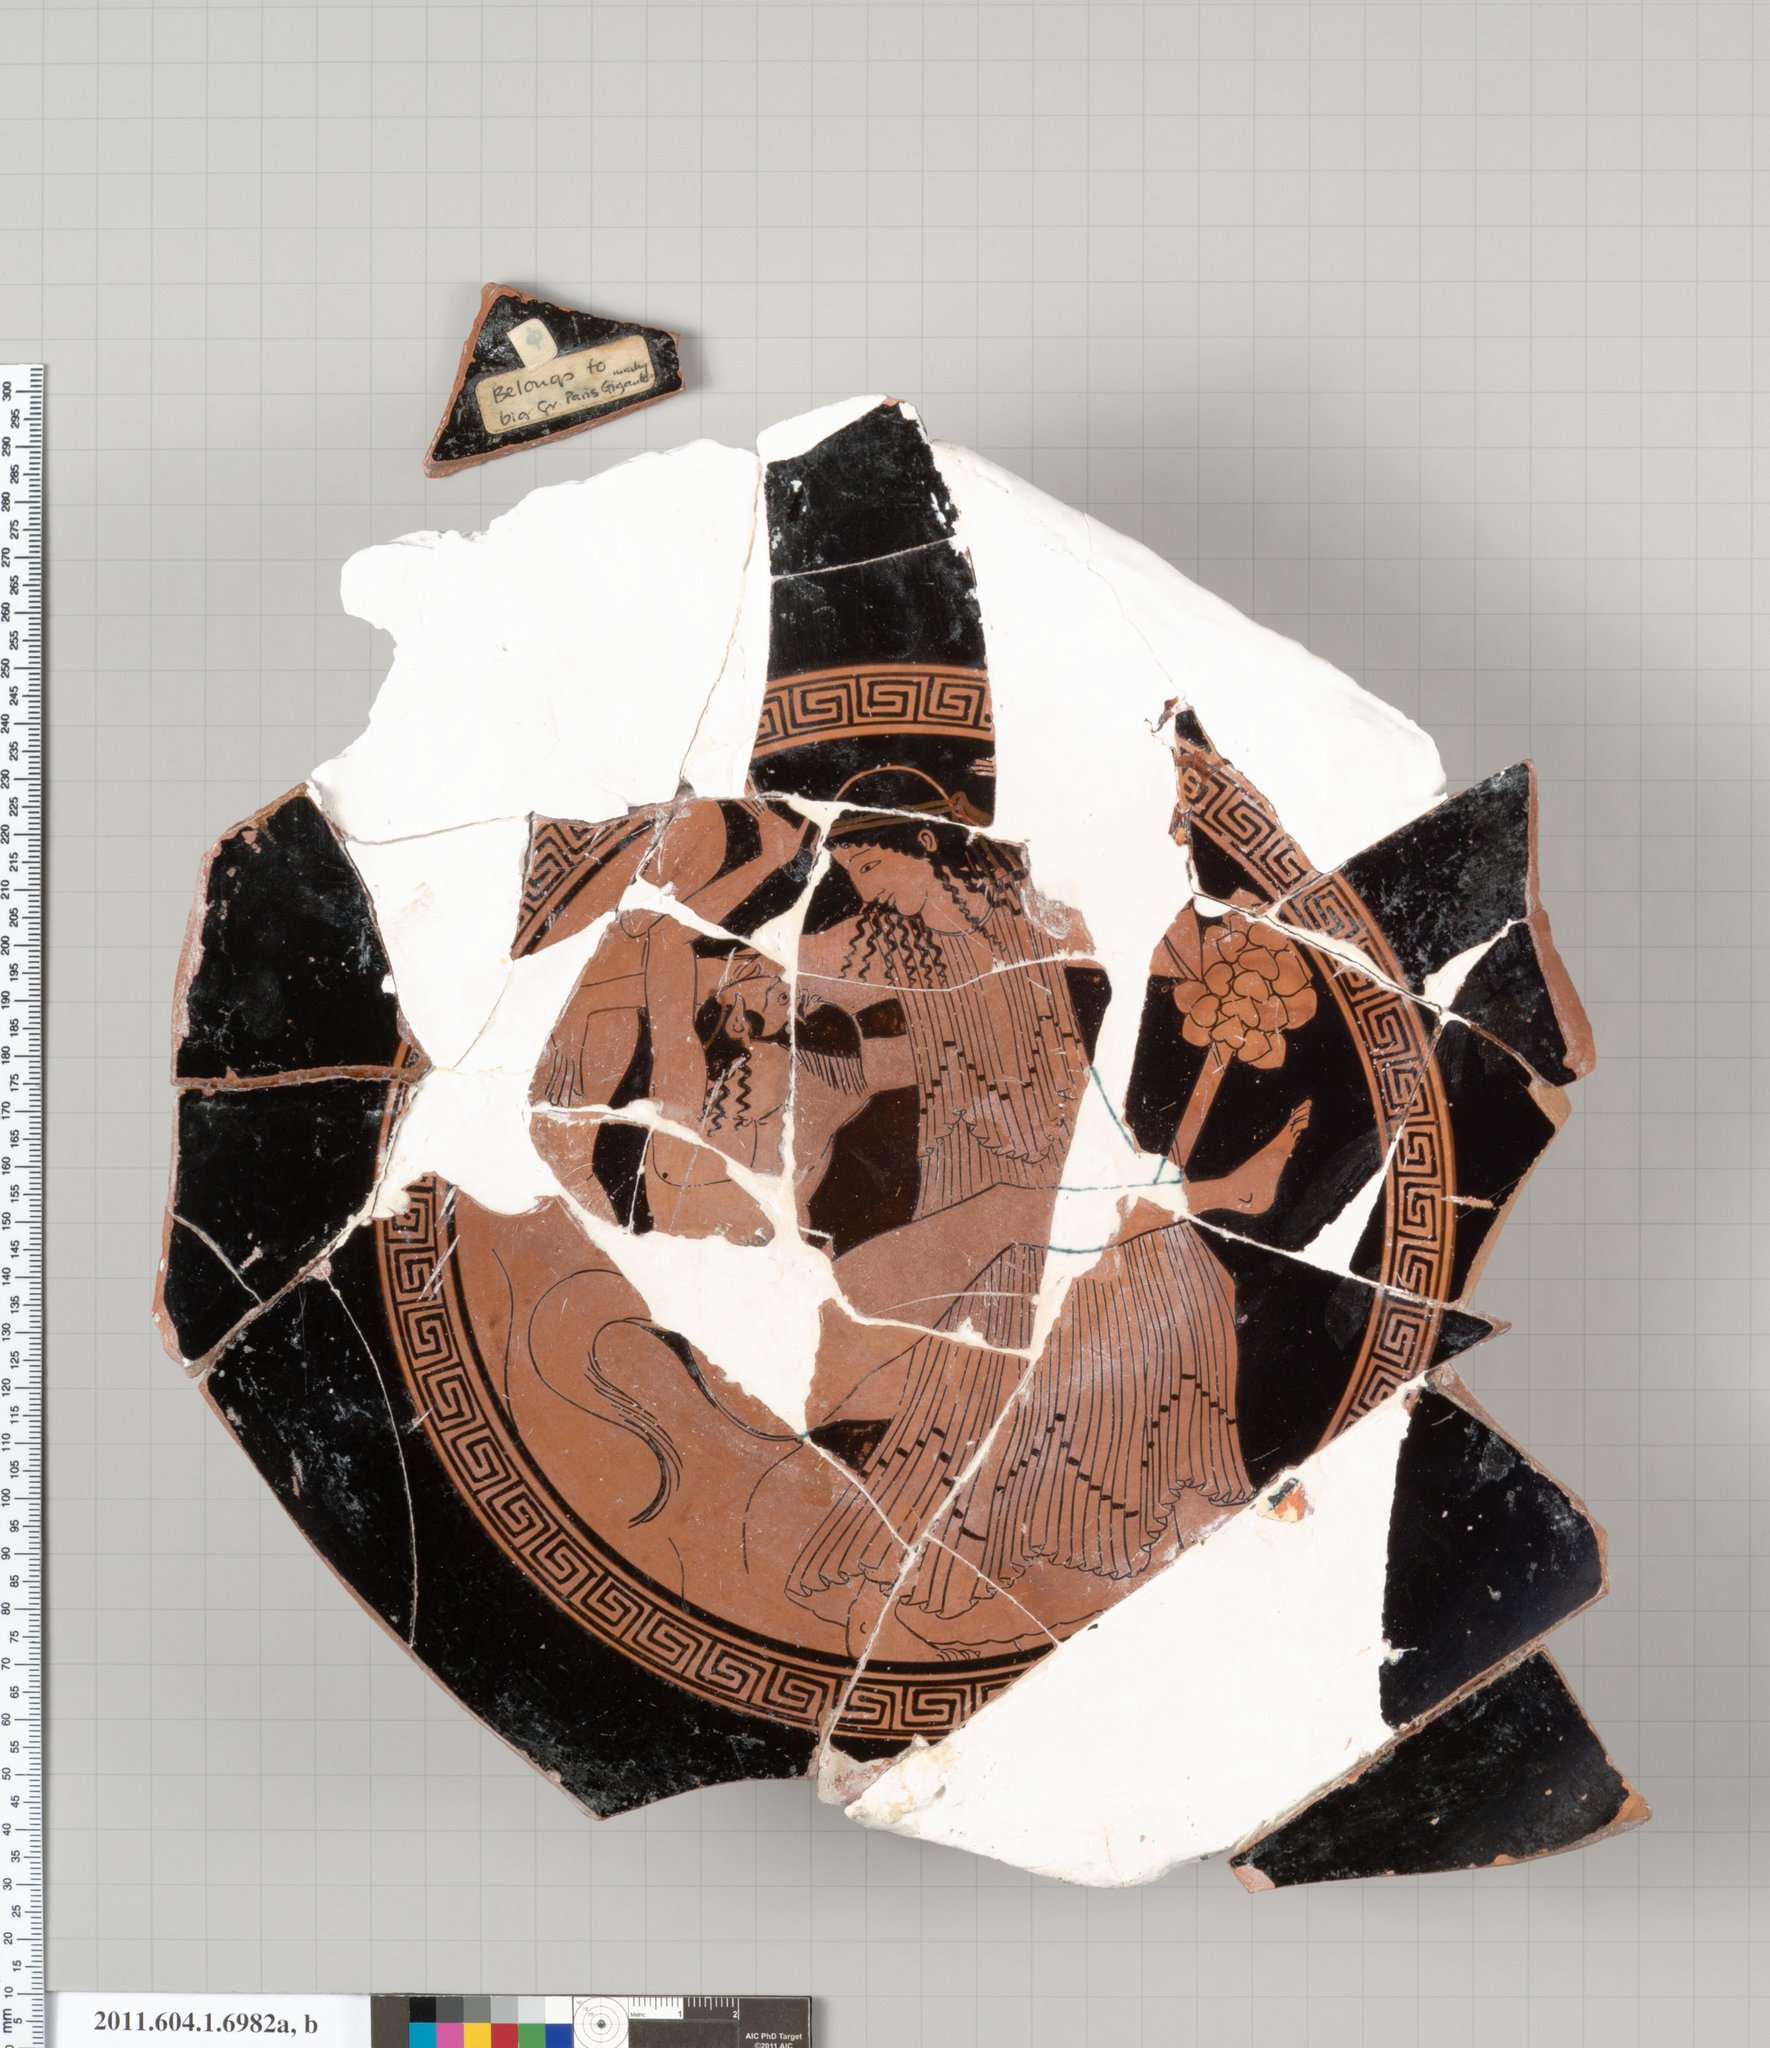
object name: kylix fragment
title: Terracotta fragments of a kylix (drinking cup)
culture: greek, attic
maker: painter of the paris gigantomachy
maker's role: artist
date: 480-470 BCE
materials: terracotta